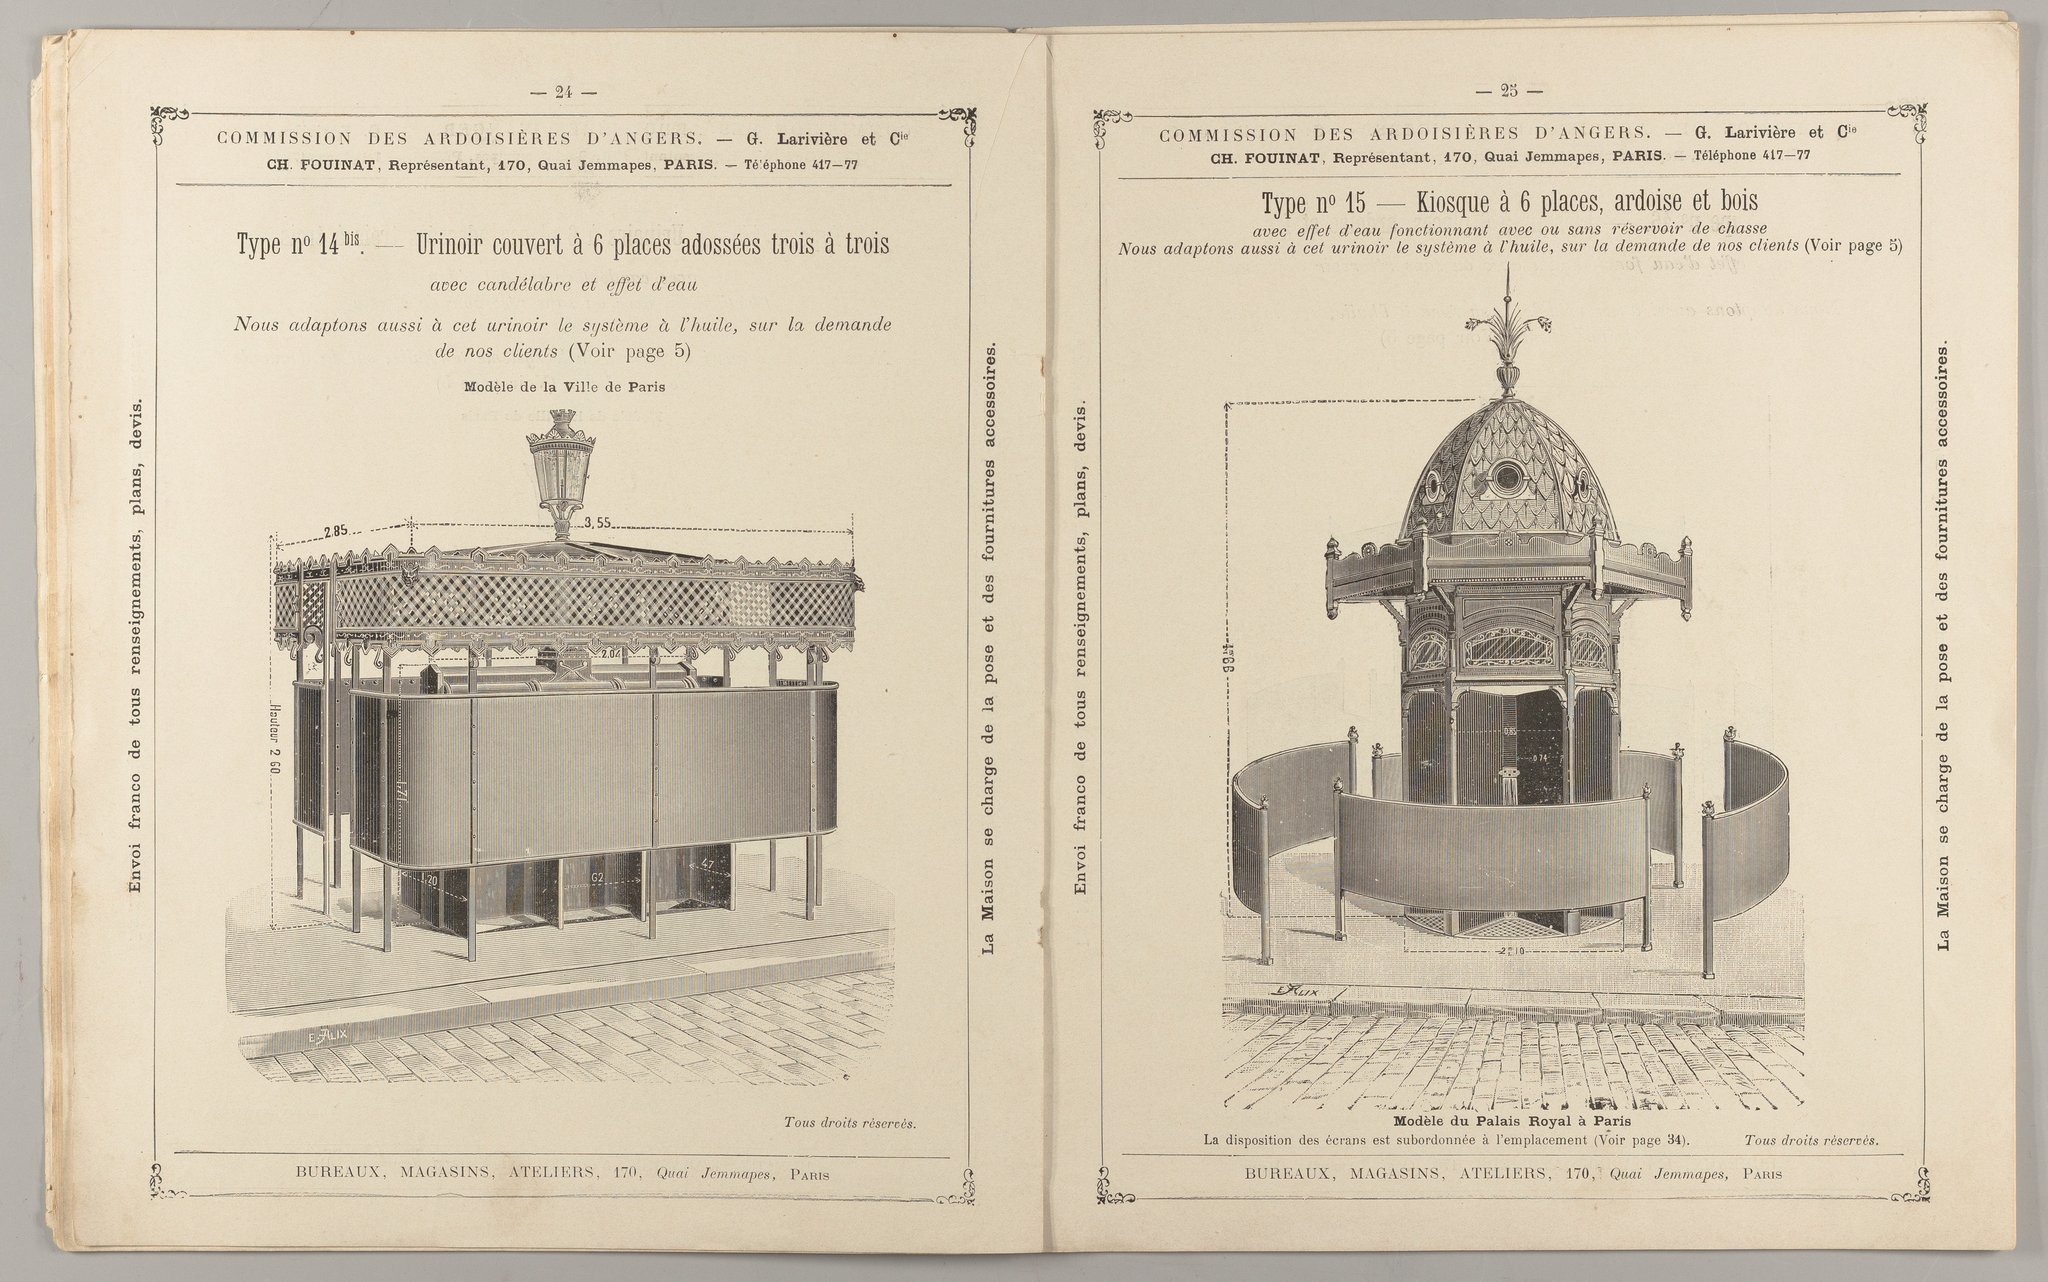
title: Urinoirs : publics et privés, kiosques, sièges et cabinets communs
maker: g. larivière et cie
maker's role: publisher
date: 1901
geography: france